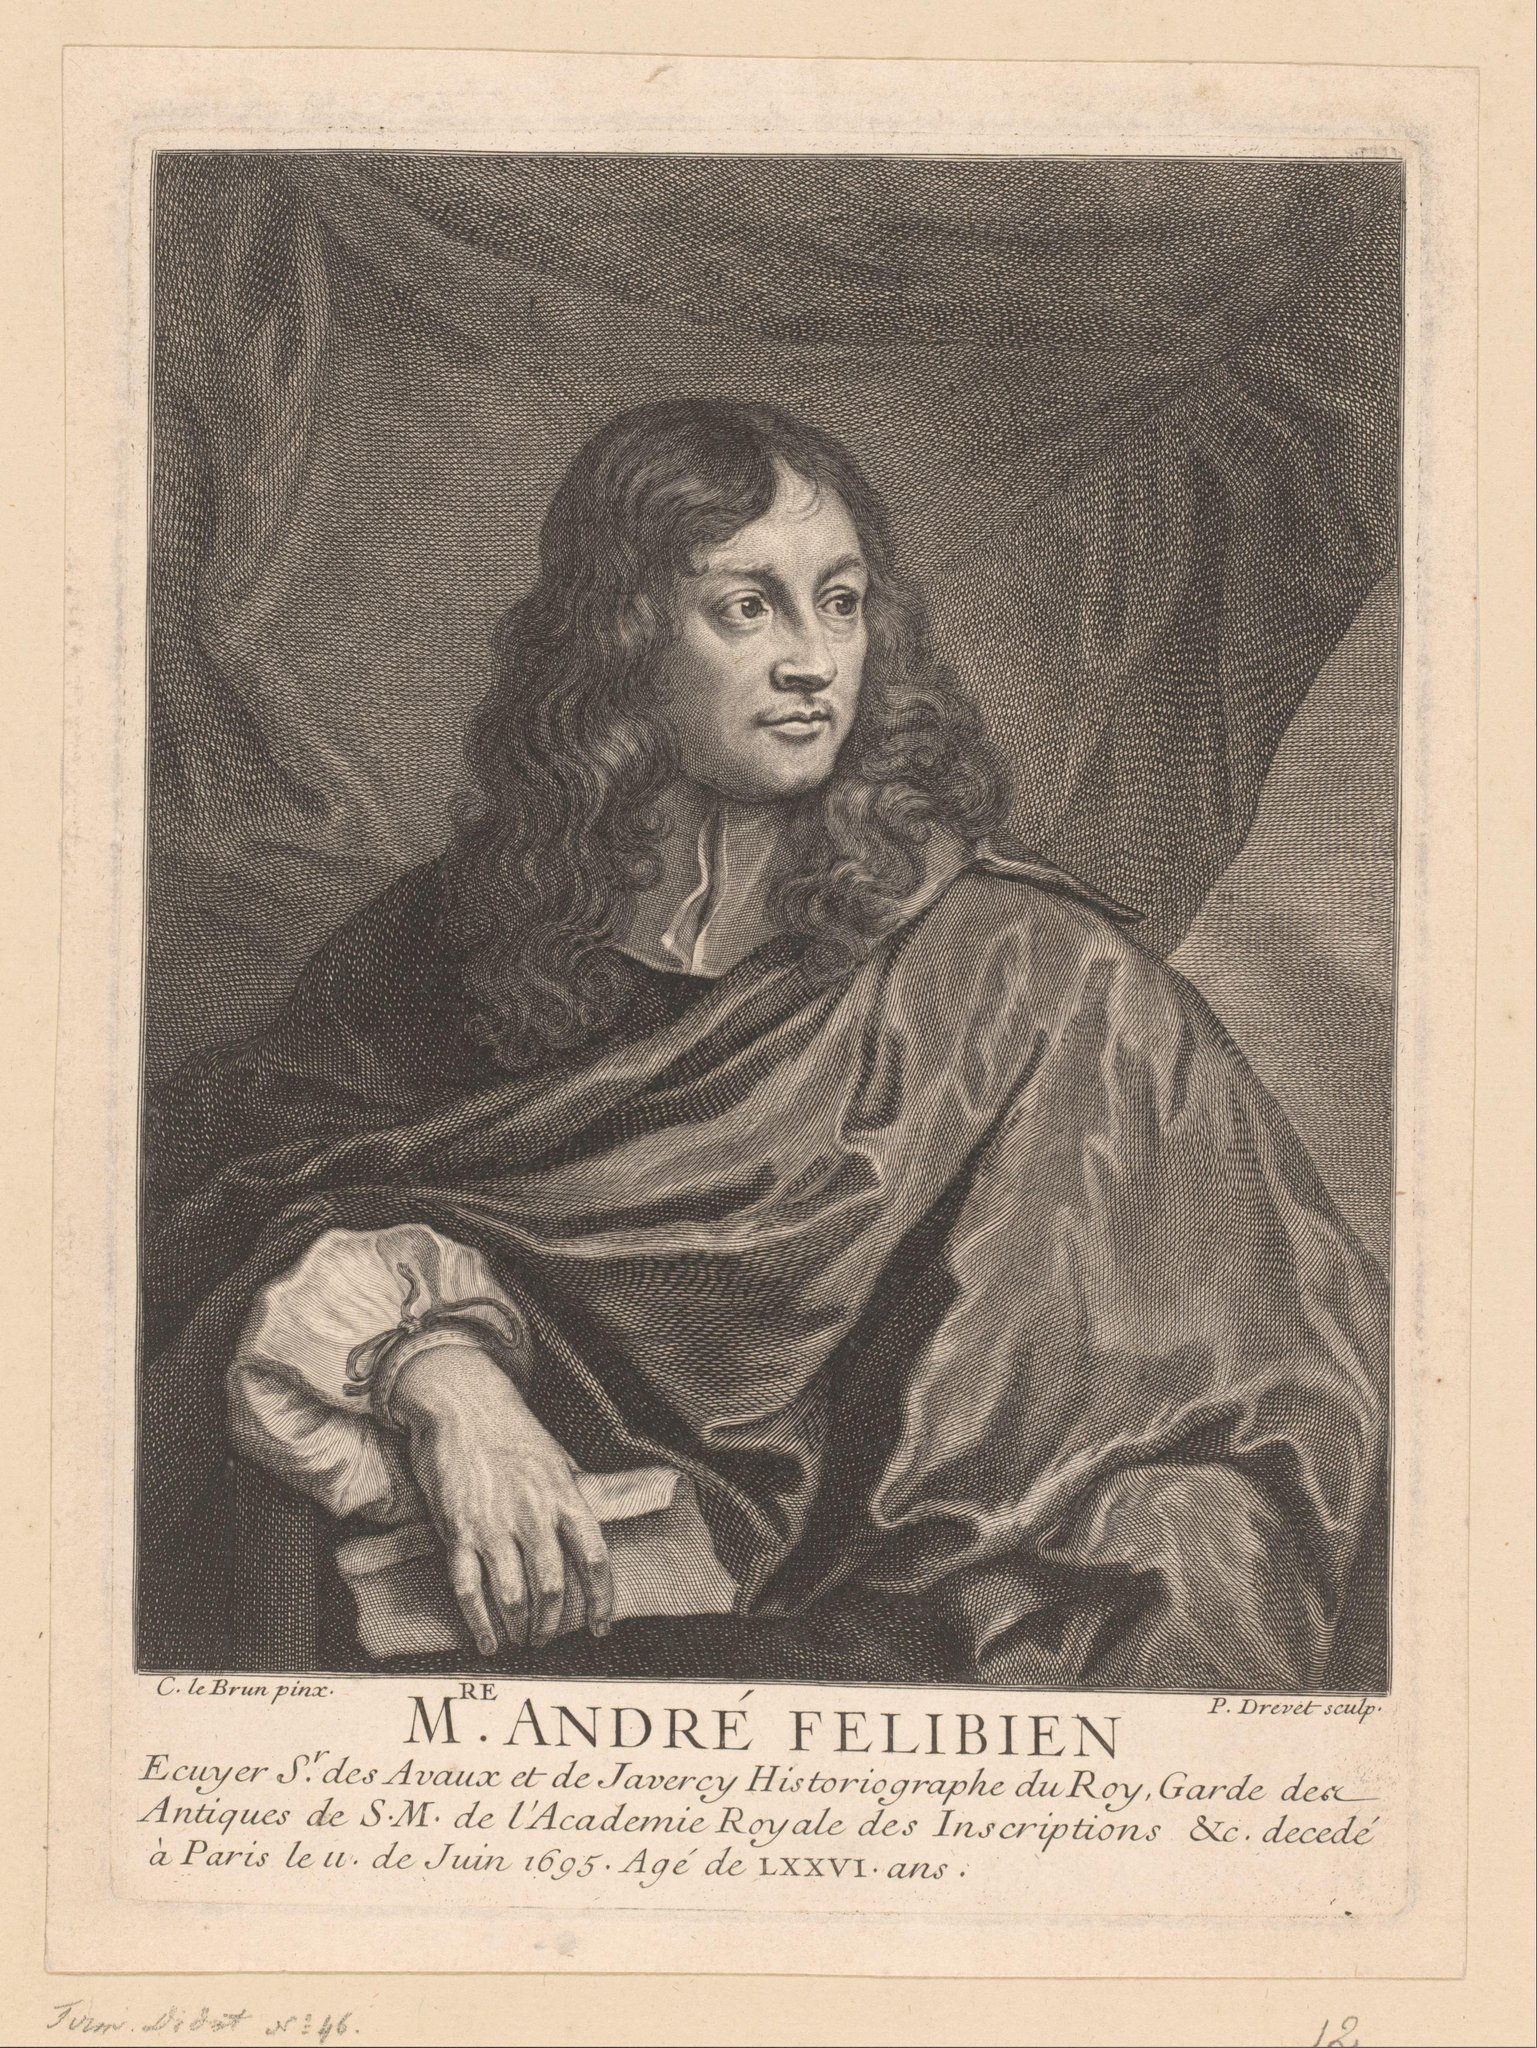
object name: print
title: Portret van André Félibien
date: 1695-1738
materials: paper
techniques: engraving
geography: france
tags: paris, andré félibien, architect in non-work situation, portrait of a writer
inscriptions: collector's mark: Lugt 240